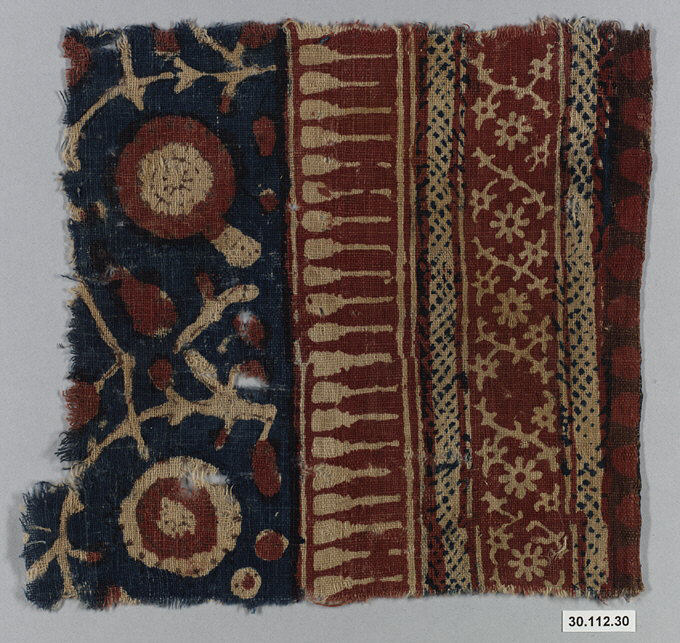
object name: textile fragment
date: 1501-1600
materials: cotton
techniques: dyeing, painting, weave, printing, resist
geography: egypt